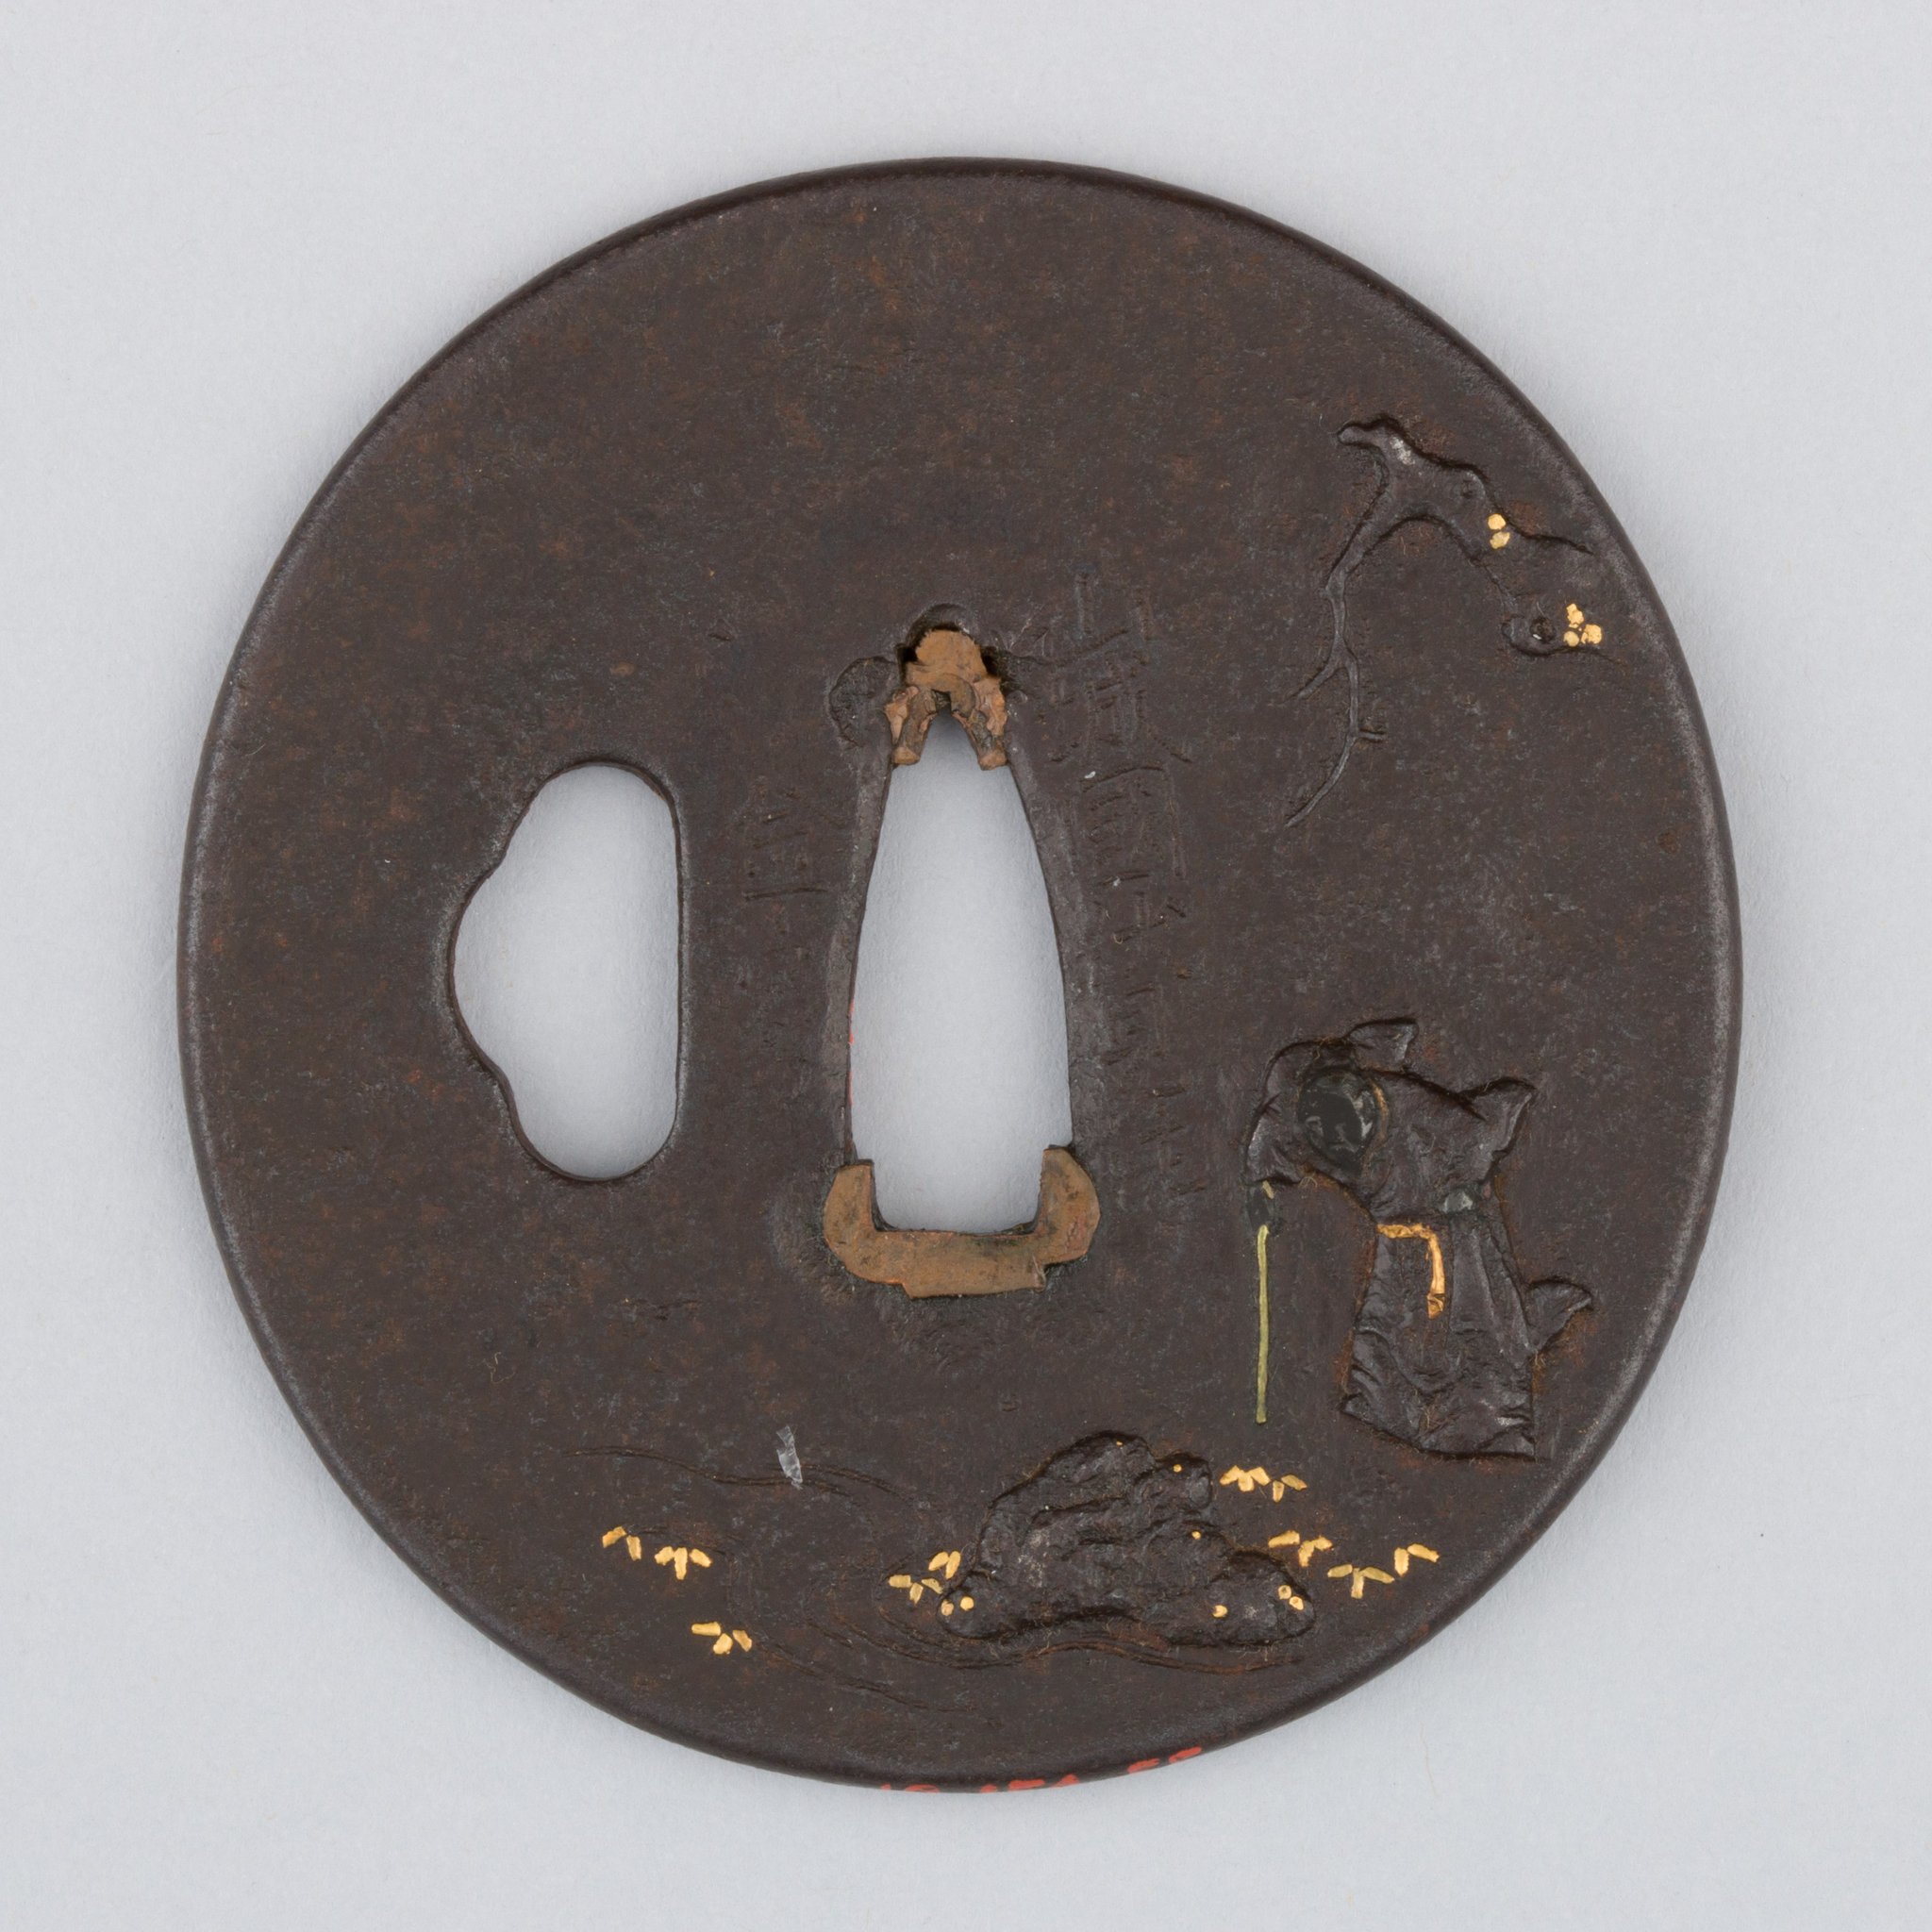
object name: sword guard tsuba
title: Sword Guard (Tsuba)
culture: japanese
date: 1615-1868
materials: copper, iron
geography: japan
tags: men